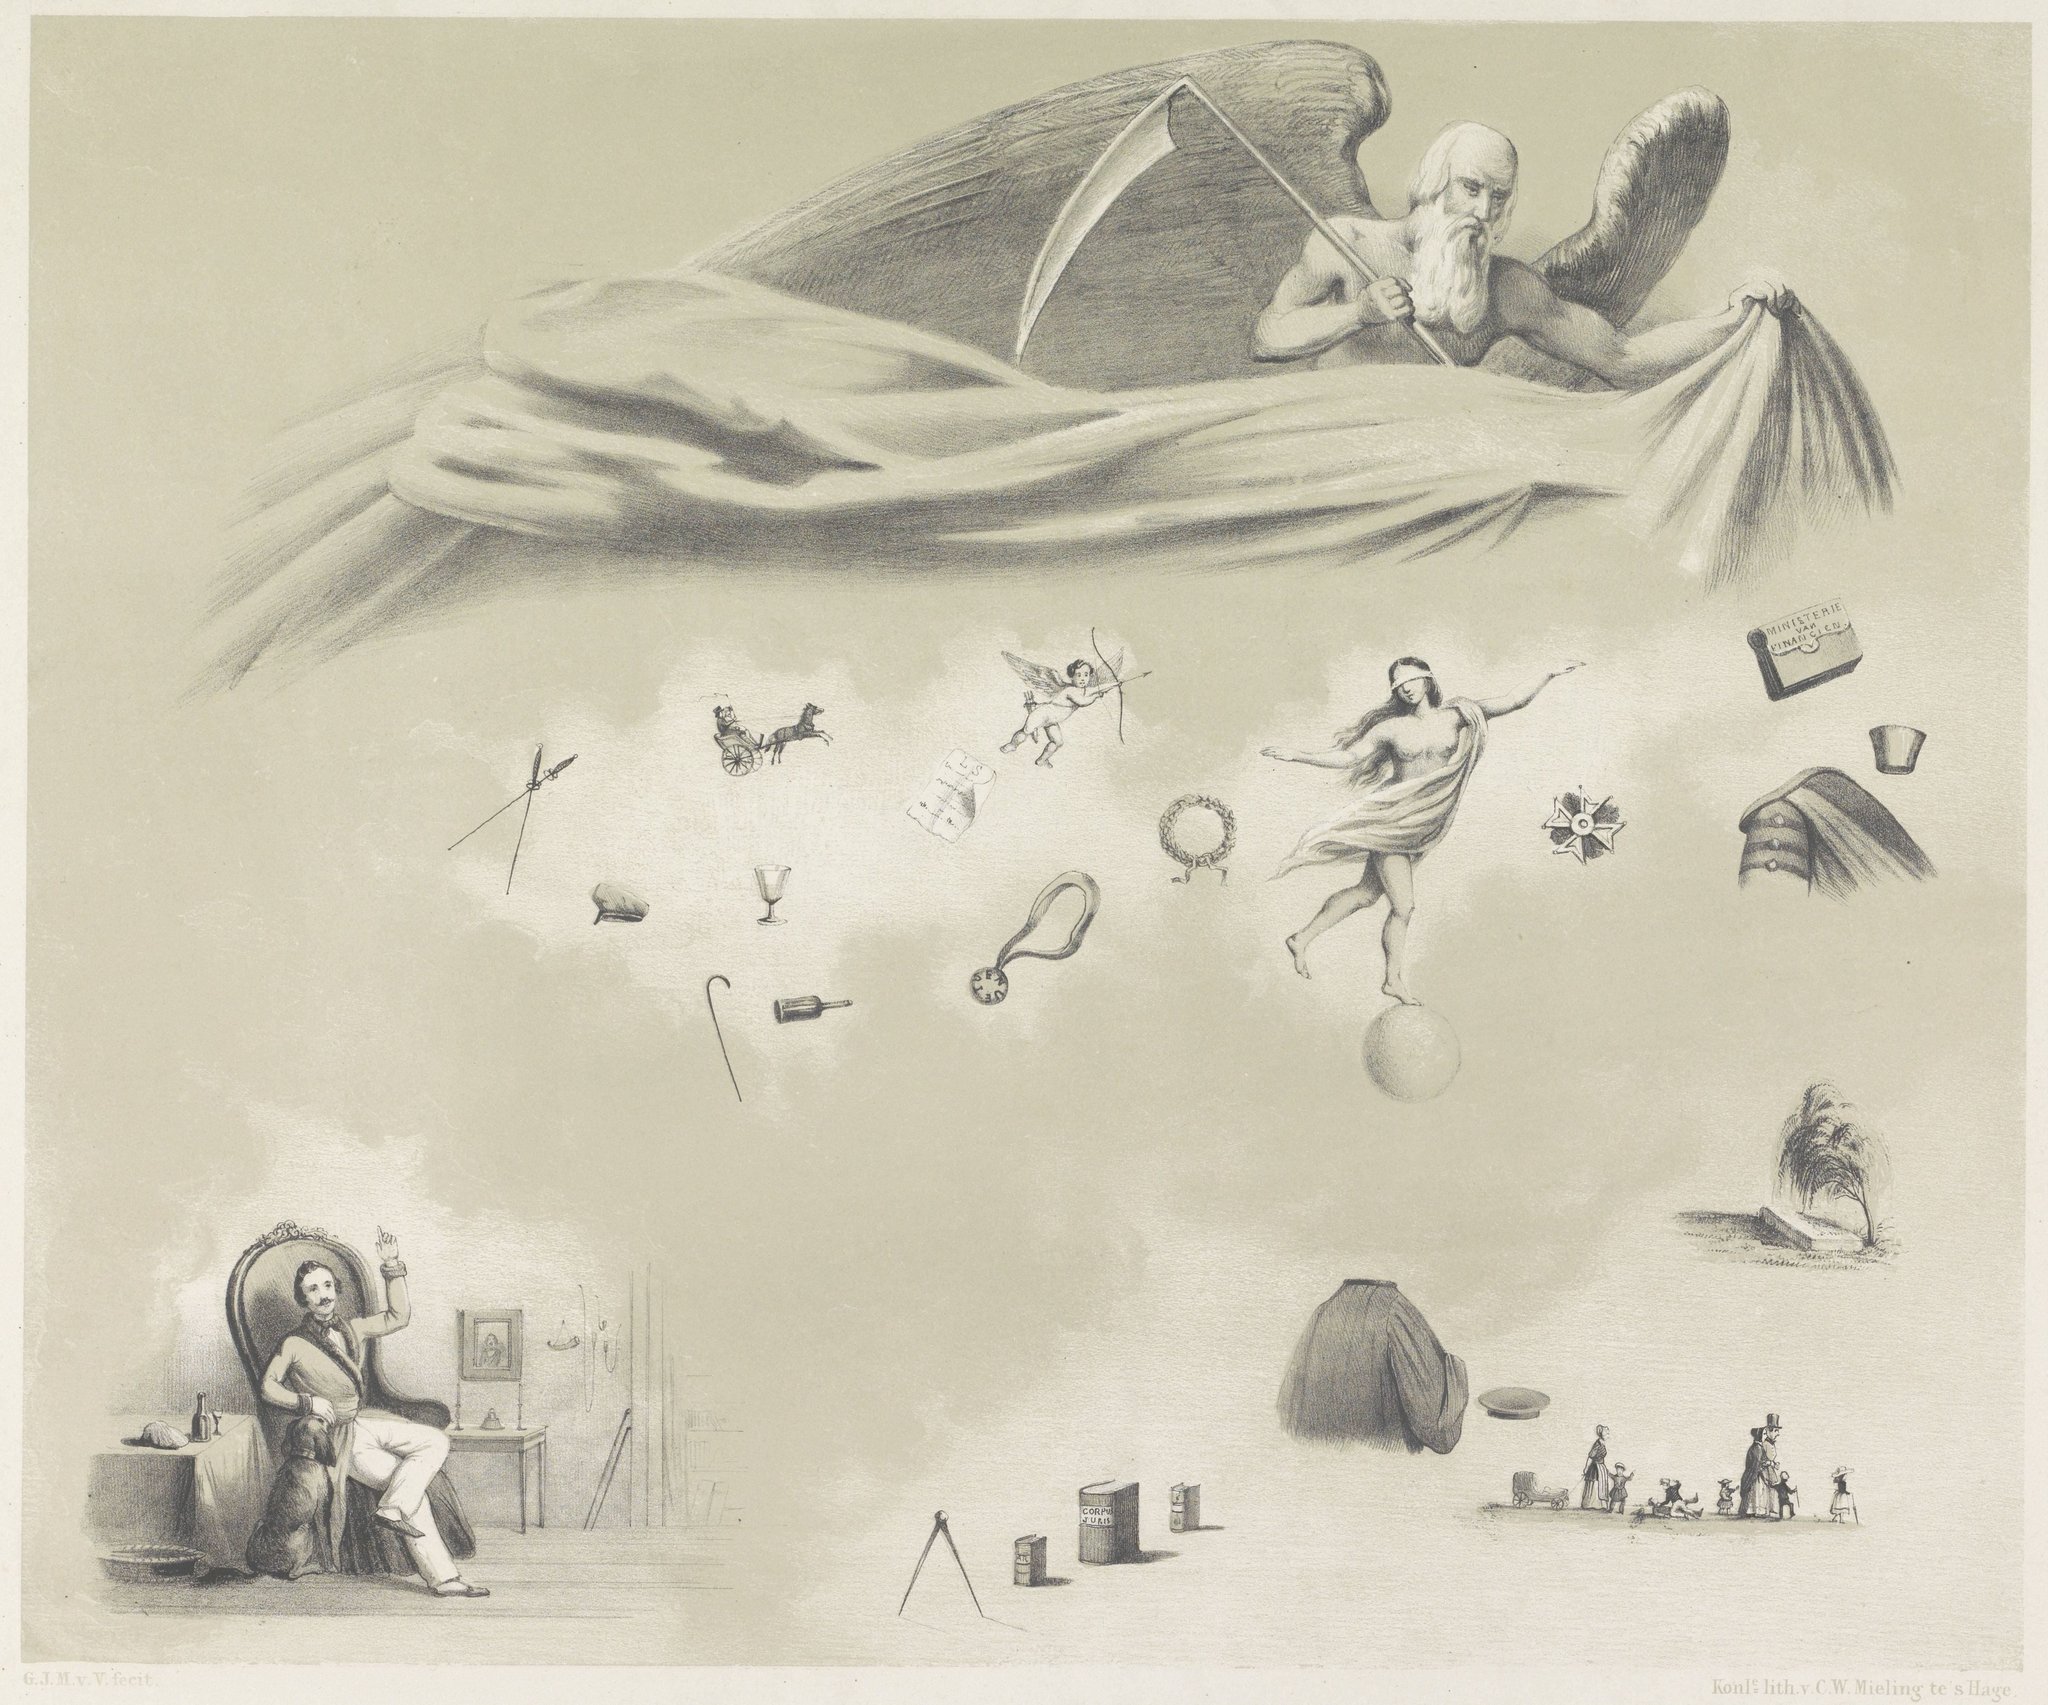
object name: cartoon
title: Spotprent uit Utrechtse studentenalmanak, 1852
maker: g.j. du marchie van voorthuysen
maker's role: lithograaf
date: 1852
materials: paper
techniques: tone lithography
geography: the hague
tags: student, utrecht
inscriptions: collector's mark: Lugt 2228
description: Spotprent uit de studentenalmanak van de Universiteit van Utrecht van het jaar 1852. Vader Tijd toont wat hij de student in de toekomst allemaal kan brengen. De student zit linksonder in een stoel.